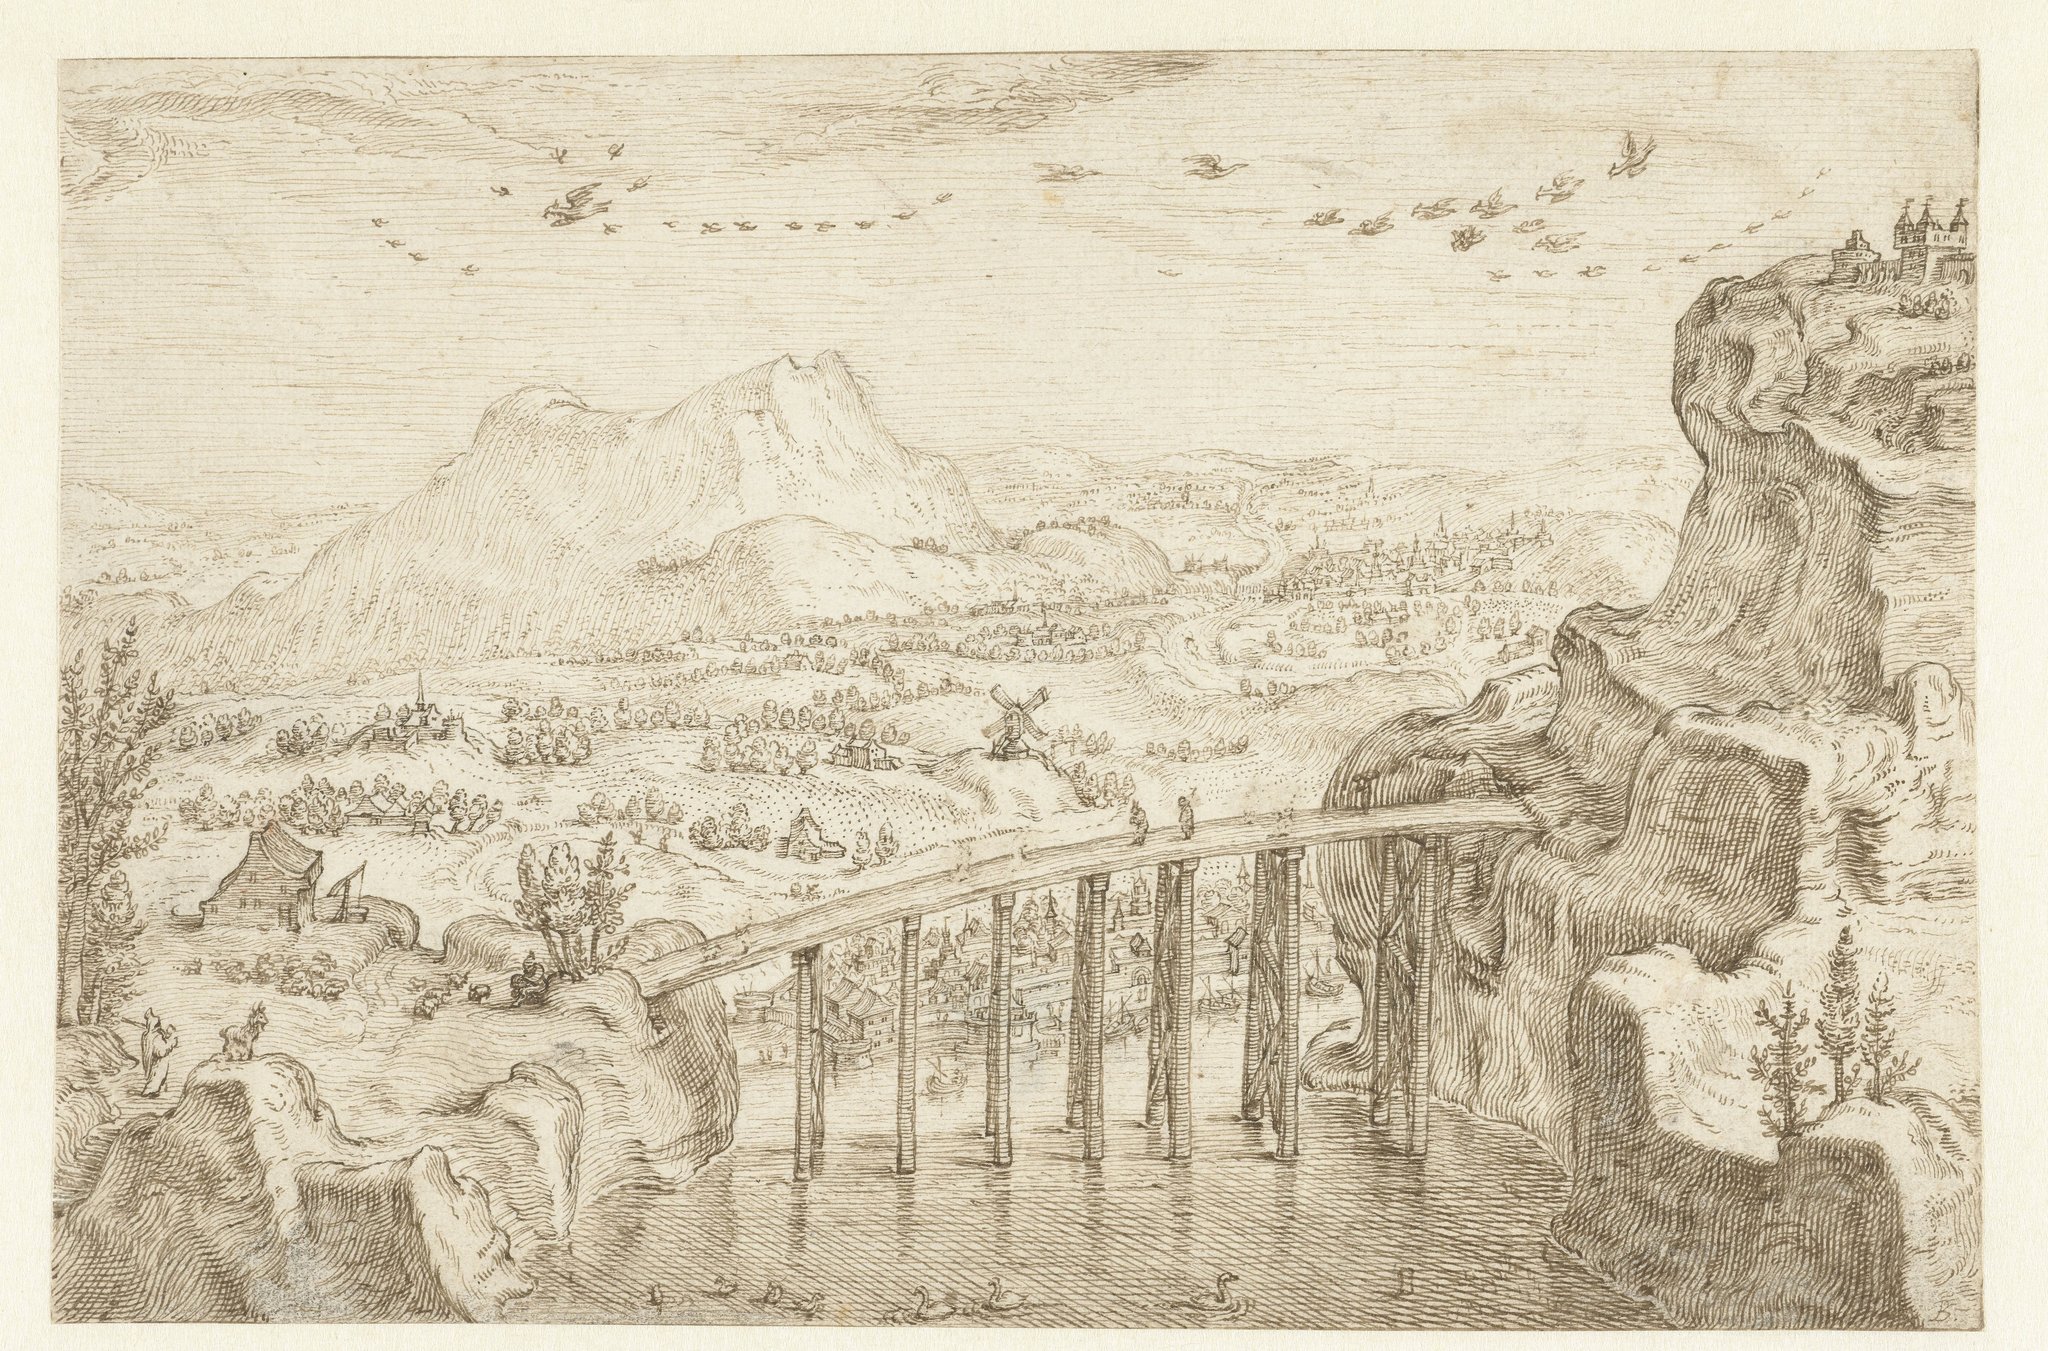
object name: drawing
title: Berglandschap met hoge brug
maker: jacob matham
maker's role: draughtsman, print maker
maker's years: 1571-1631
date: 1609-1619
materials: ink, paper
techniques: pen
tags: landscape with bridge, viaduct or aqueduct, mountains